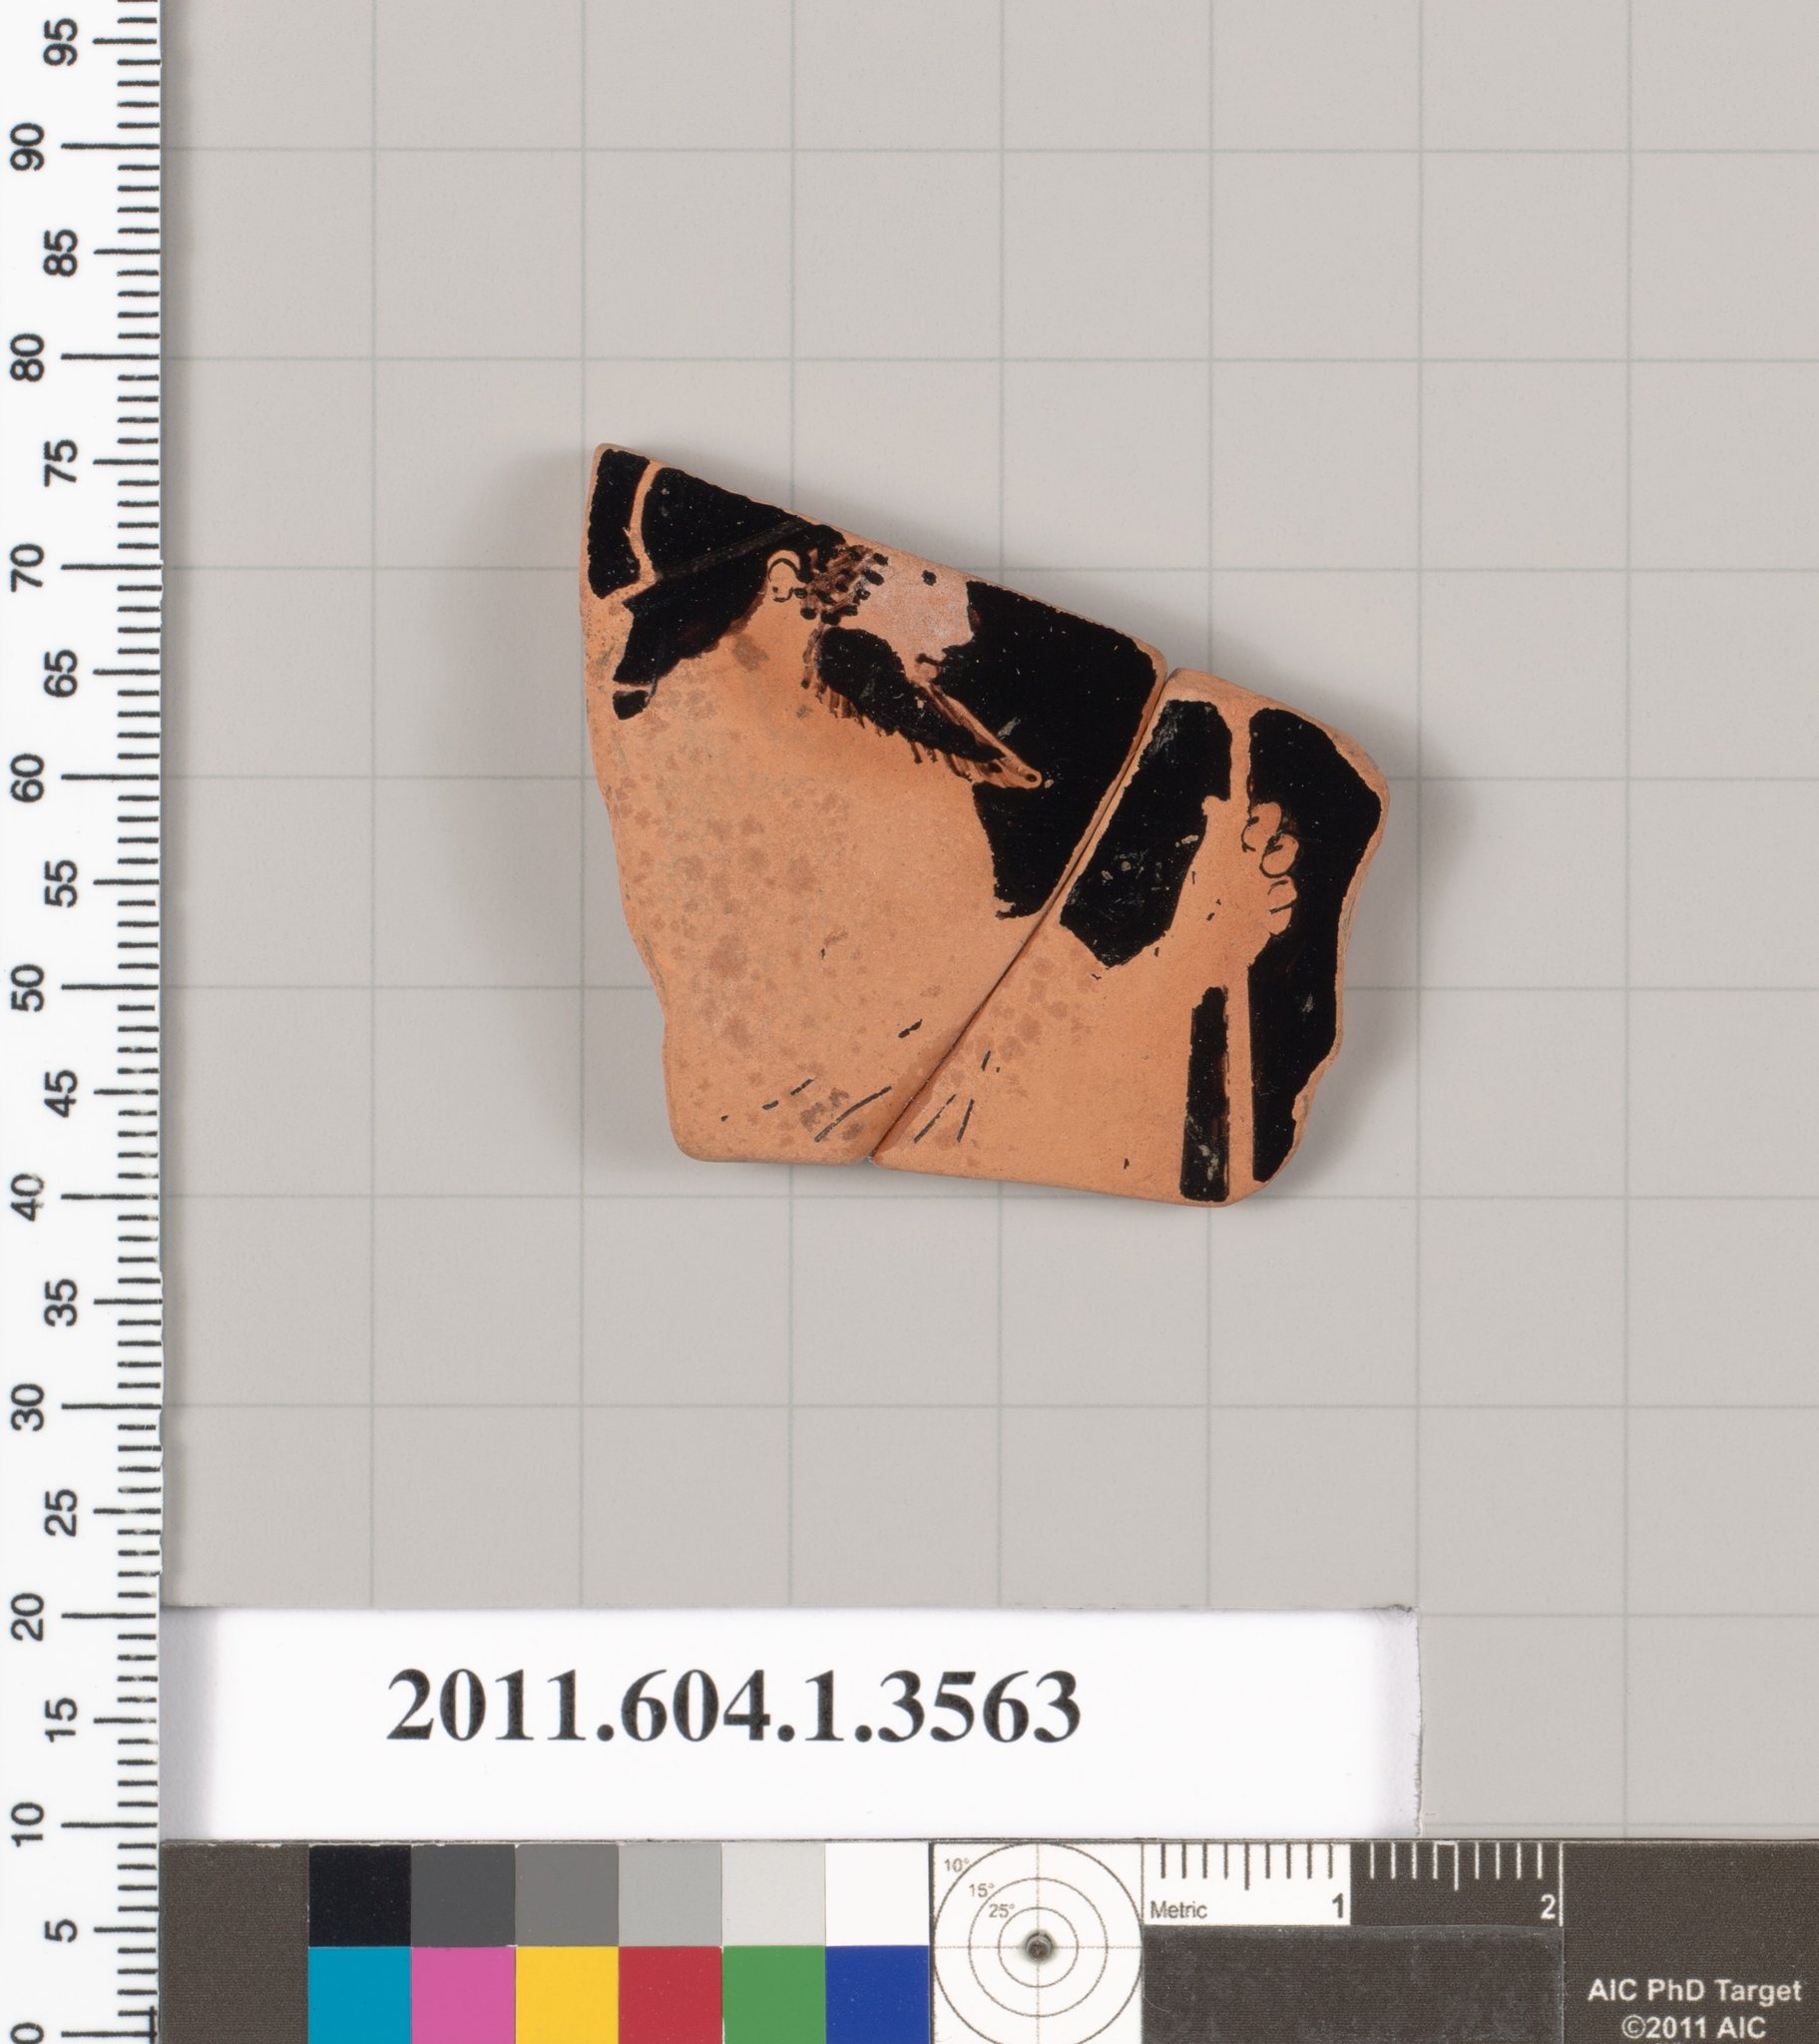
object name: kylix fragment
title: Terracotta fragment of a kylix (drinking cup)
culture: greek, attic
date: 490-470 BCE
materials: terracotta